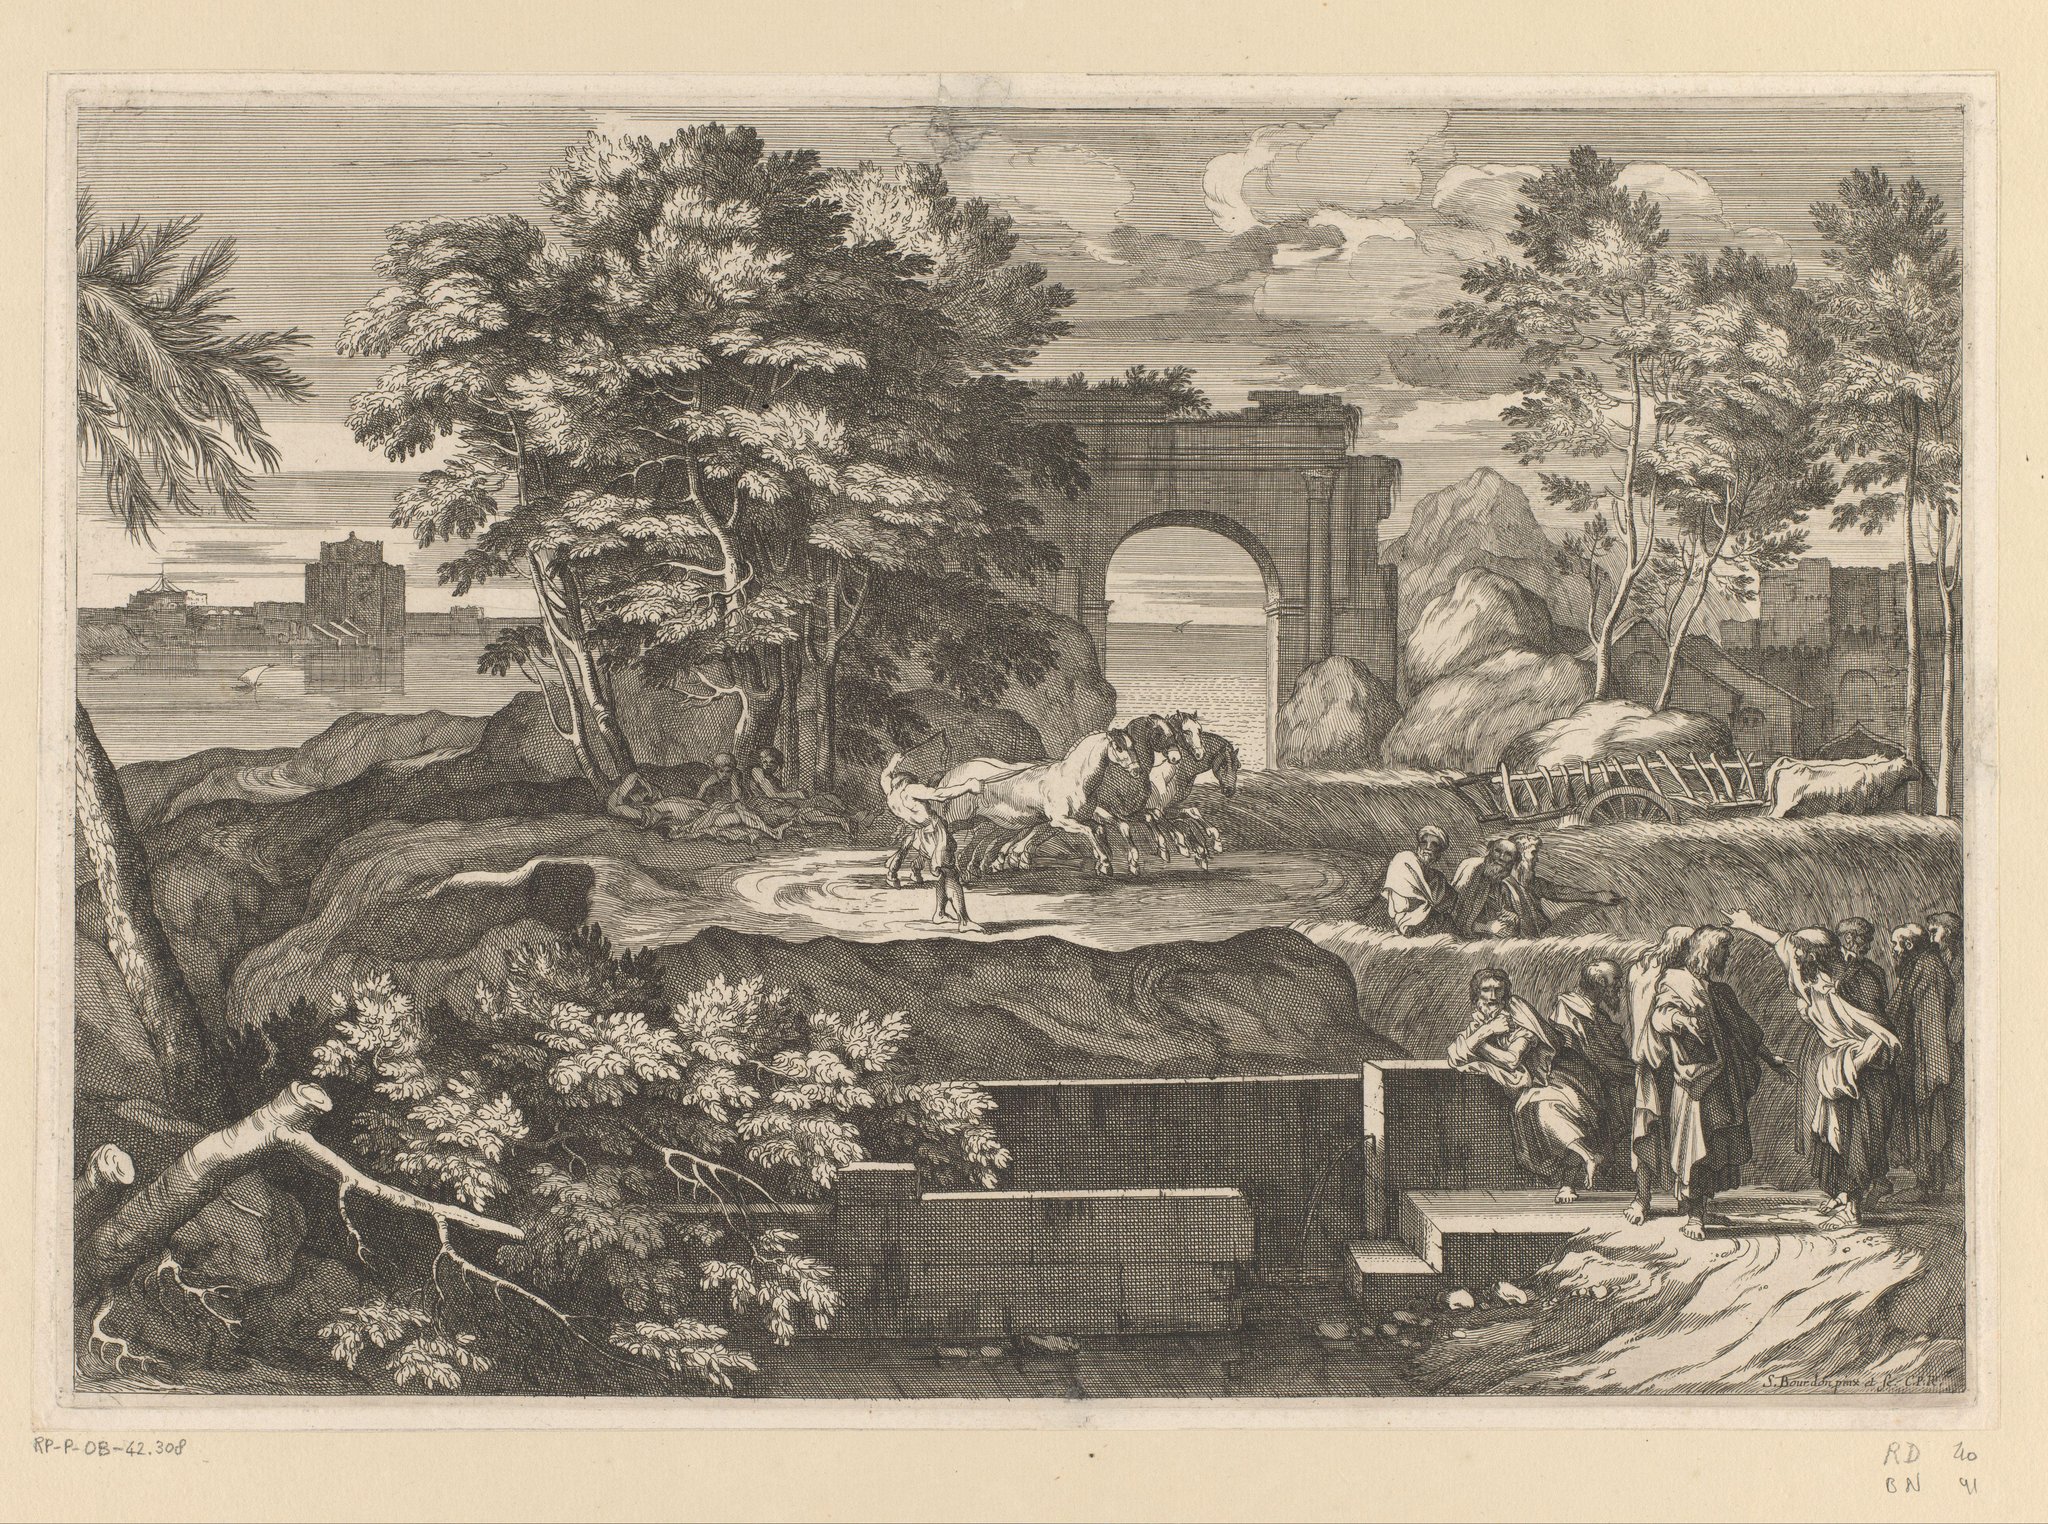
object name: print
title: Landschap met rijschool en Christus met zijn discipelen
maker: sébastien bourdon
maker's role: draughtsman, painter, print maker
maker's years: 1616-1671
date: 1626-1671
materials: paper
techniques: etching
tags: landscapes, christ explaining his doctrine to the apostles and disciples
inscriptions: collector's mark: Lugt 240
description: Maakt deel uit van een serie van twaalf prenten van landschappen met enkele Bijbelse taferelen.